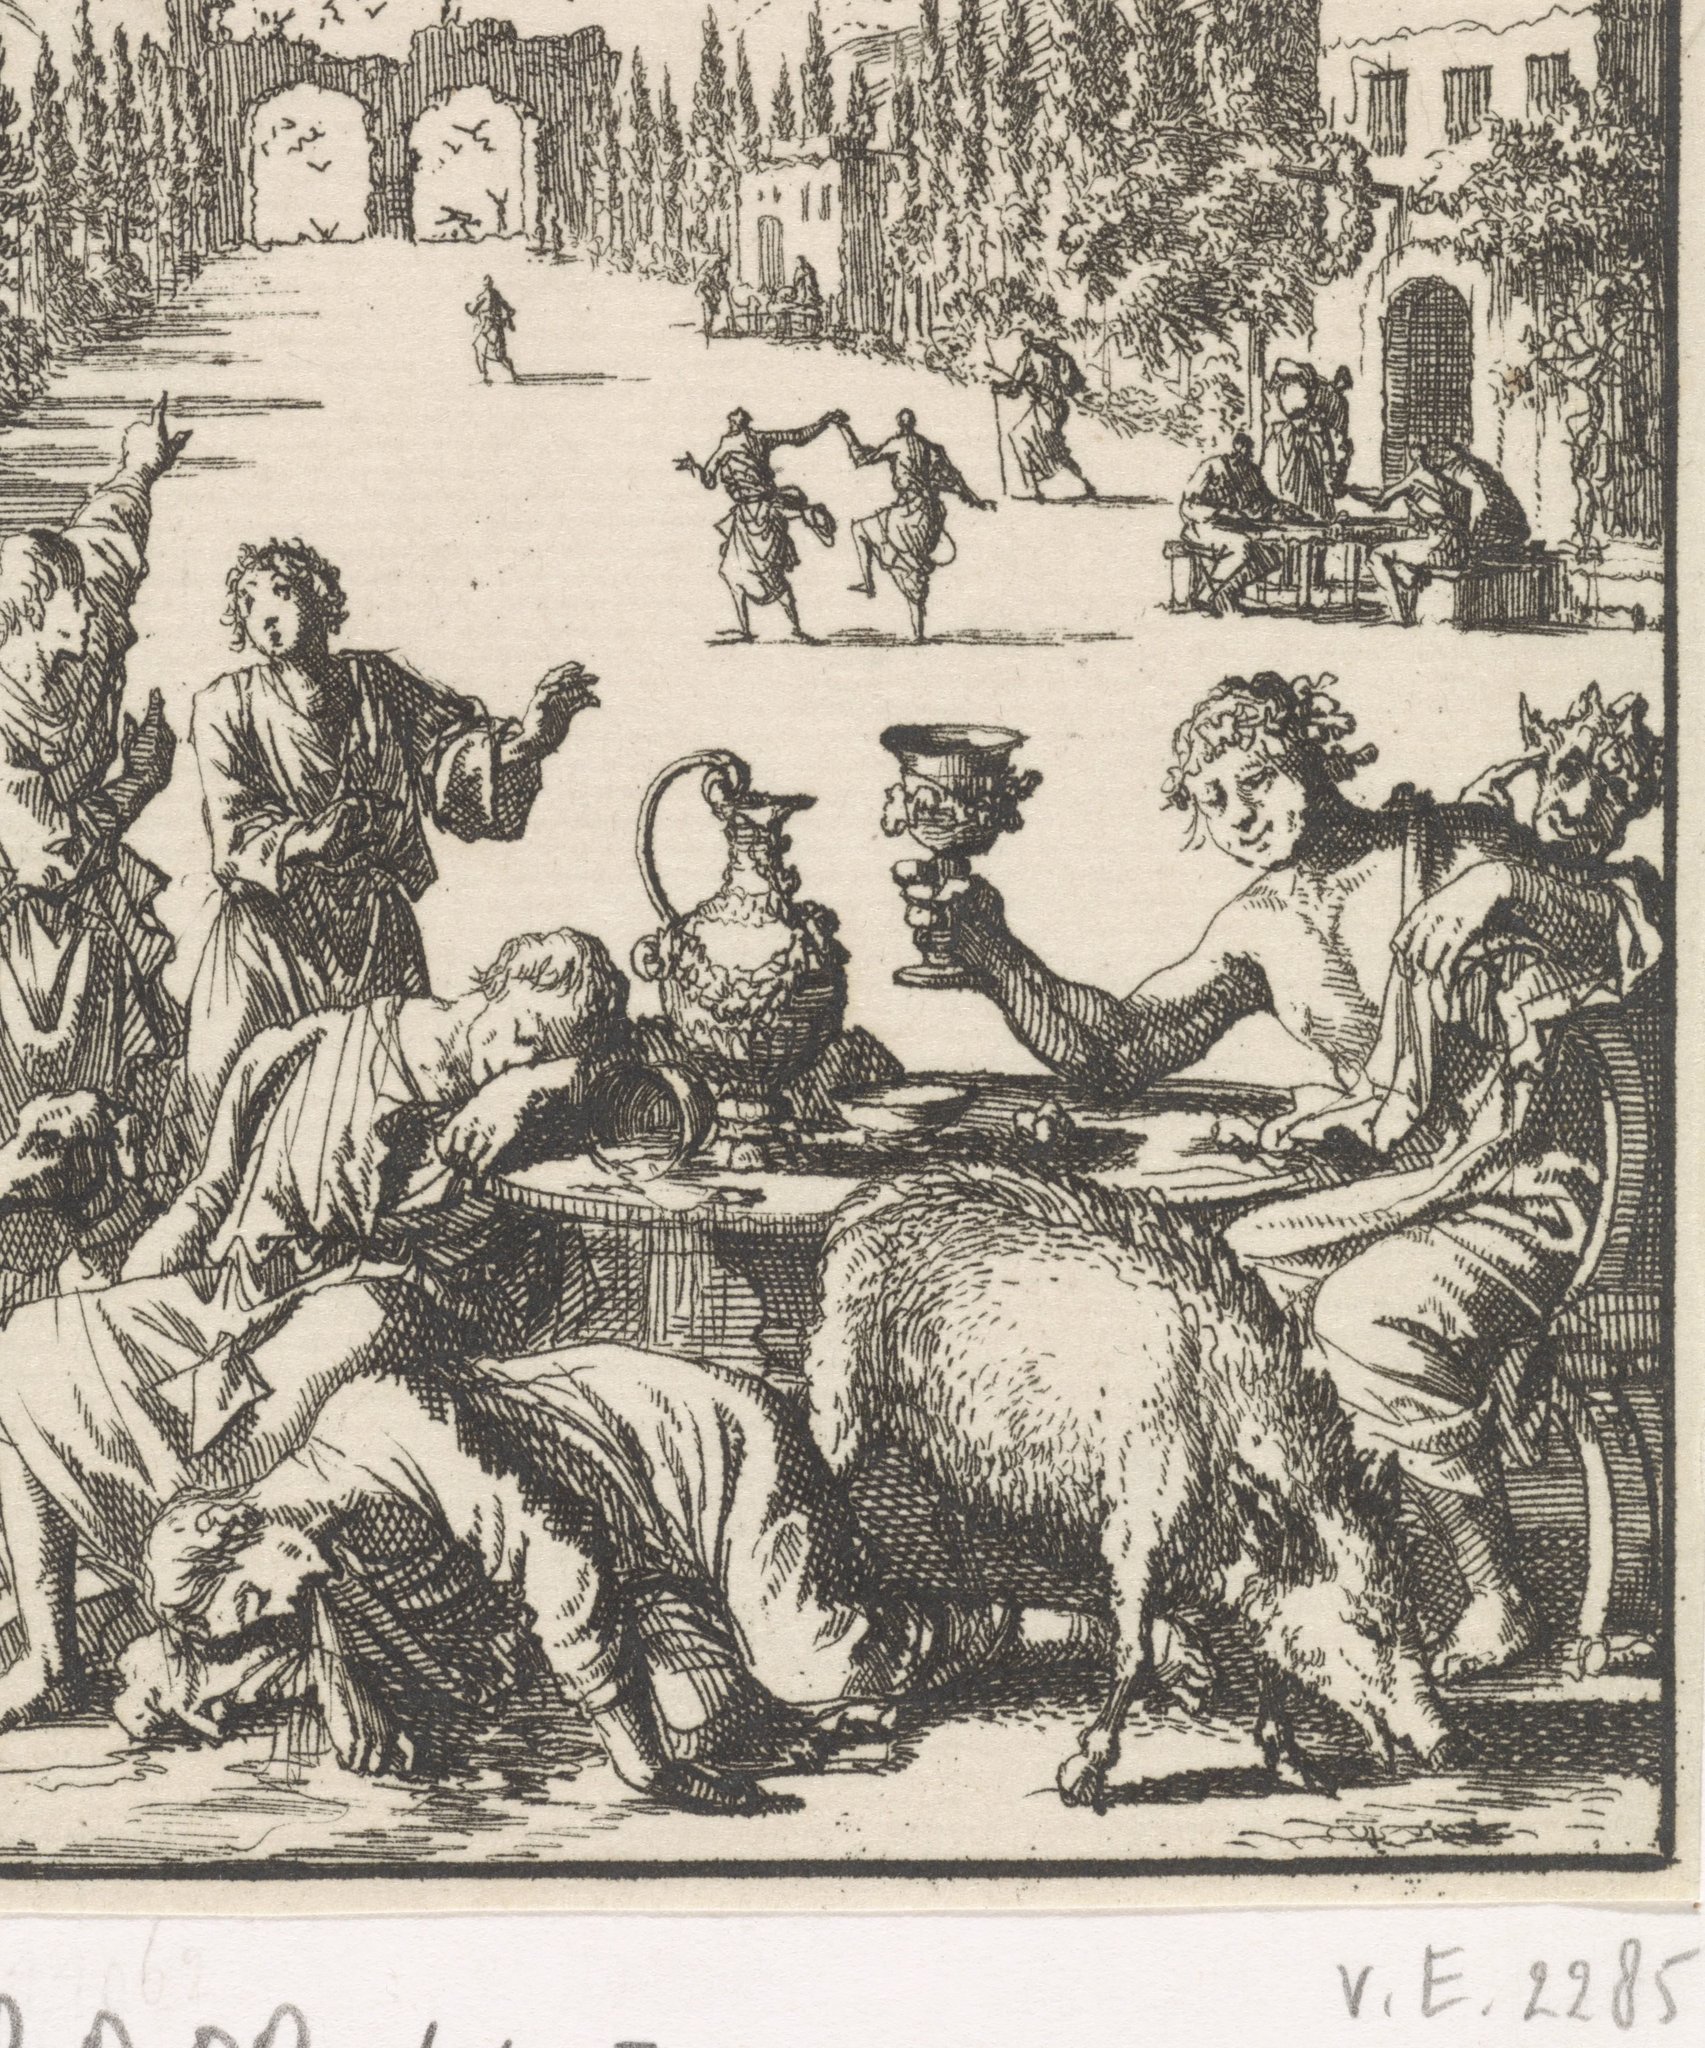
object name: print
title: Drunkenness and Gluttony Lead to Hell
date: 1699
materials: paper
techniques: etching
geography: amsterdam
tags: pig, gluttony, intemperance, 'gula'; 'gola', 'ingordigia', 'ingordigia overo avidità', 'voracità' (ripa) ~ personification of one of the seven deadly sins, entrance of hell as gate, drunkenness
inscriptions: collector's mark: Lugt 2228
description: The drunkards in the foreground will wind up in hell: ‘while Drunkenness at first charms, it ends in soot and bitterness.’ So begins the accompanying warning by the Englishwoman Elisabeth Jocelin in the parenting book she wrote for her unborn daughter. It was published in 1624, two years after her death in childbirth. Jan Luyken made 17 illustrations for the book’s Dutch translation.